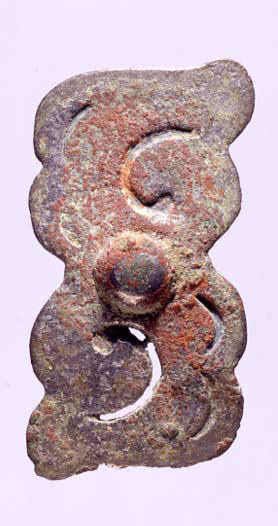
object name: belt ornament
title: Belt Ornament with Zoomorphic Design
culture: chinese or mongolian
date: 600-401 BCE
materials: bronze